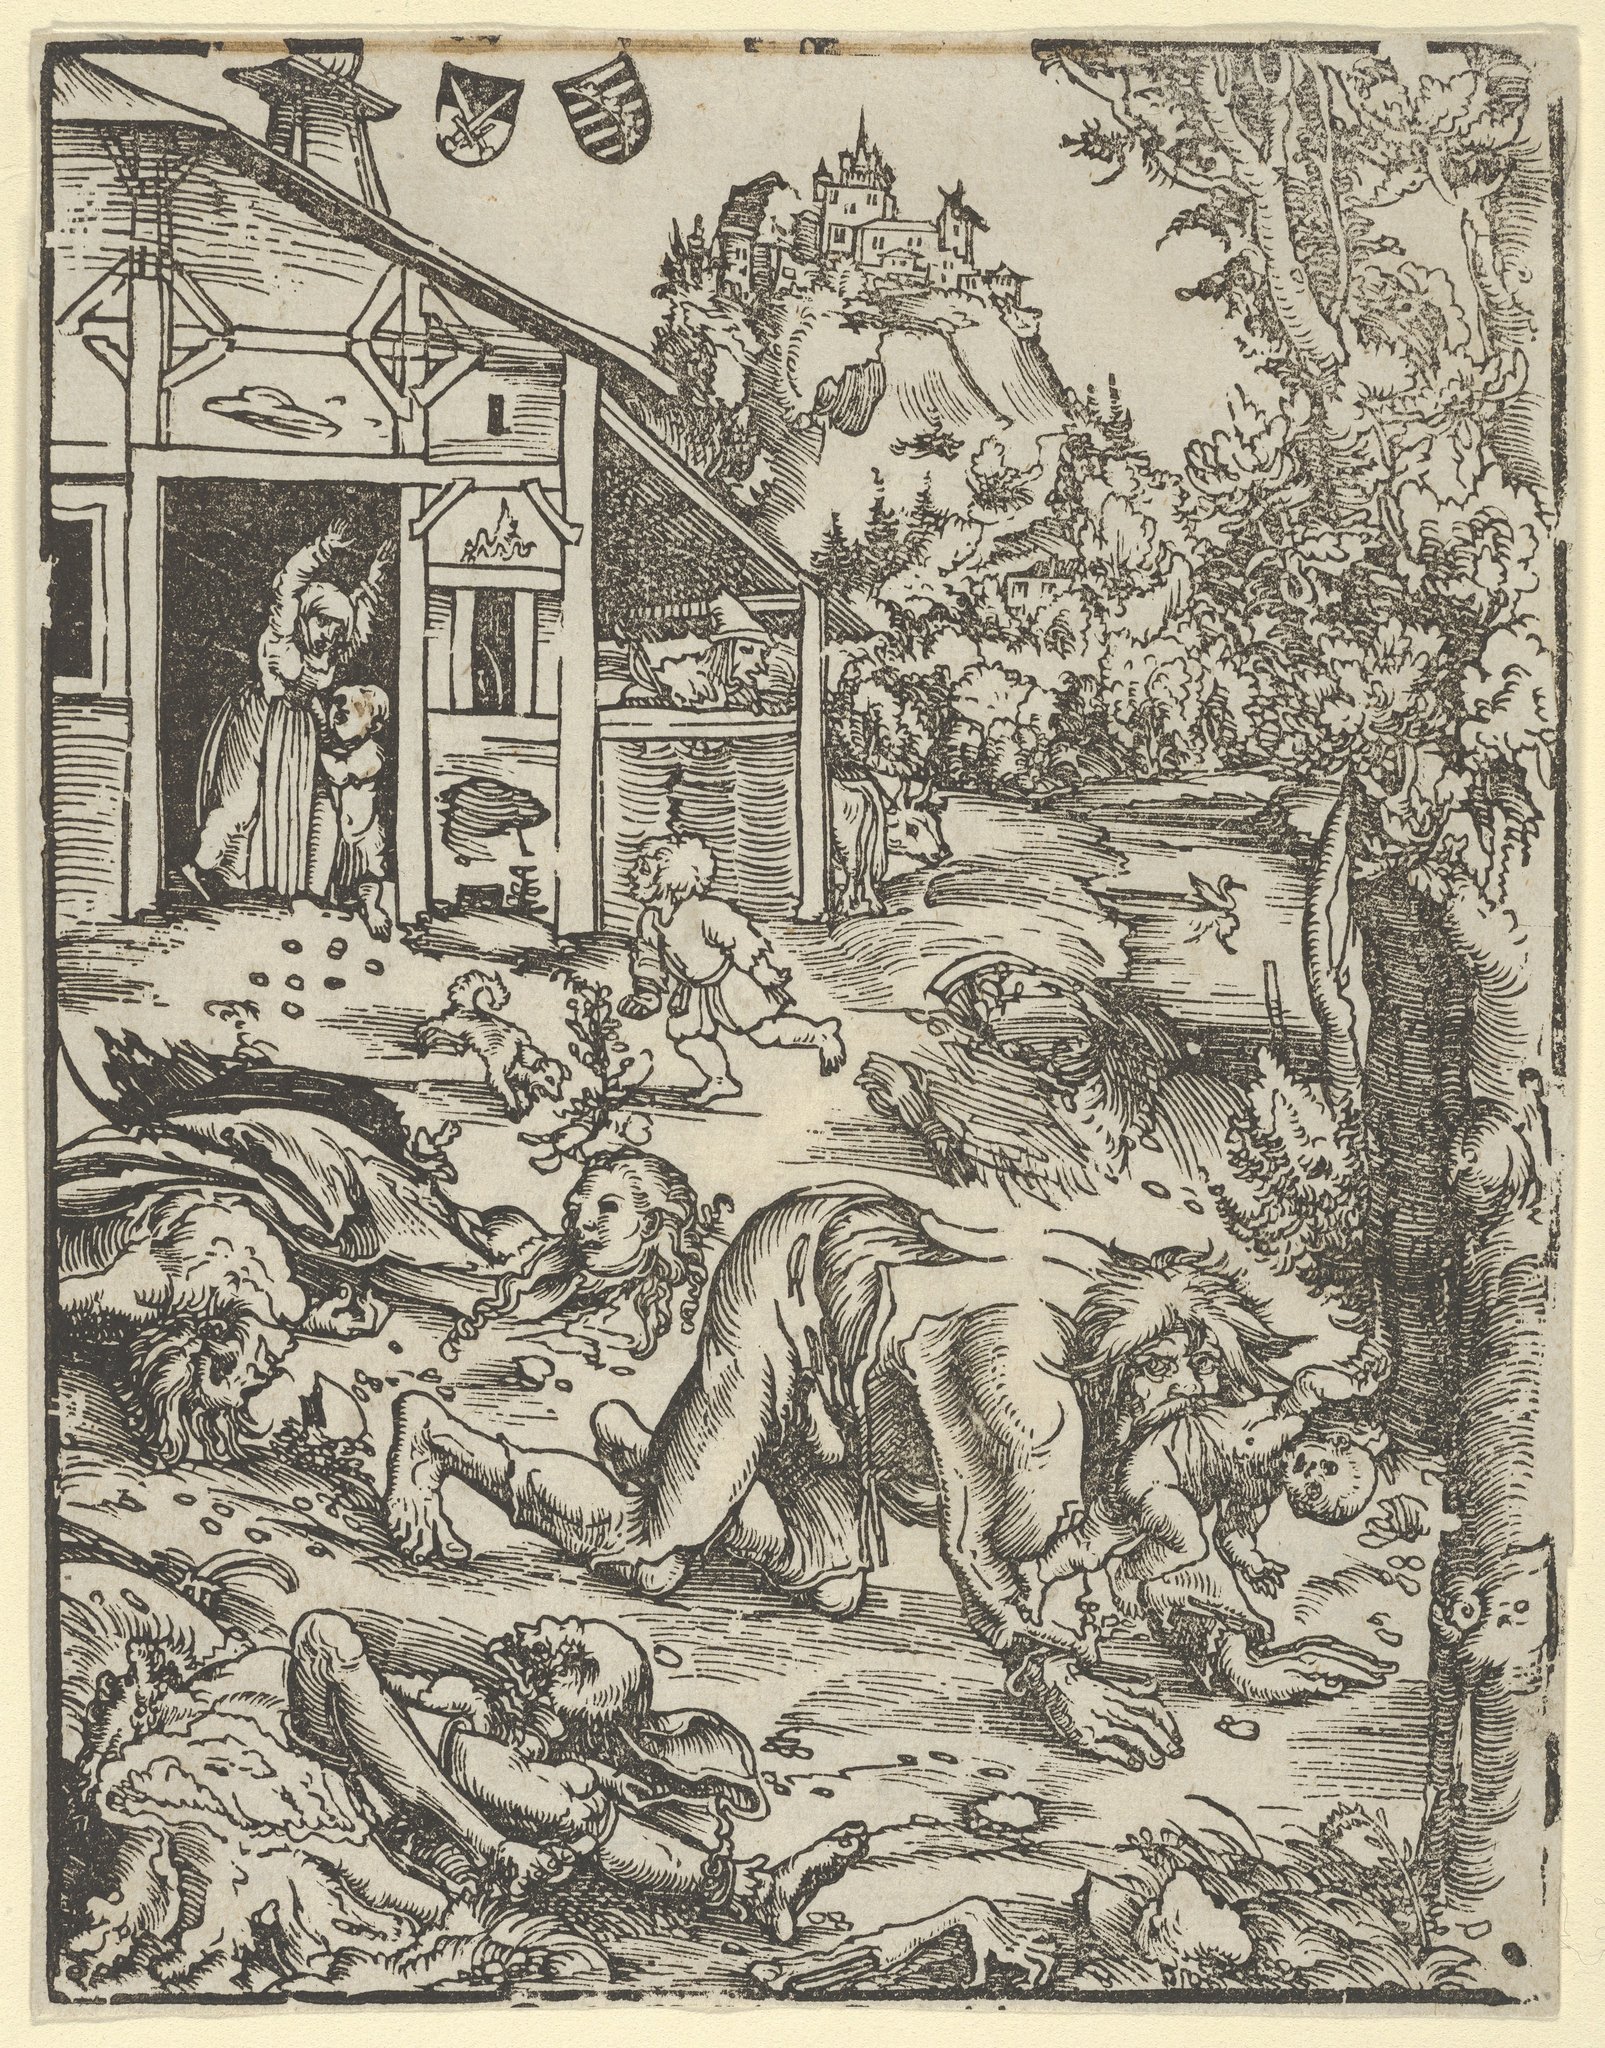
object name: print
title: The Werewolf or the Cannibal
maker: lucas cranach the elder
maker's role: artist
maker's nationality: german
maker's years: 1472-1553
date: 1472-1553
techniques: woodcut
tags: children,men,women